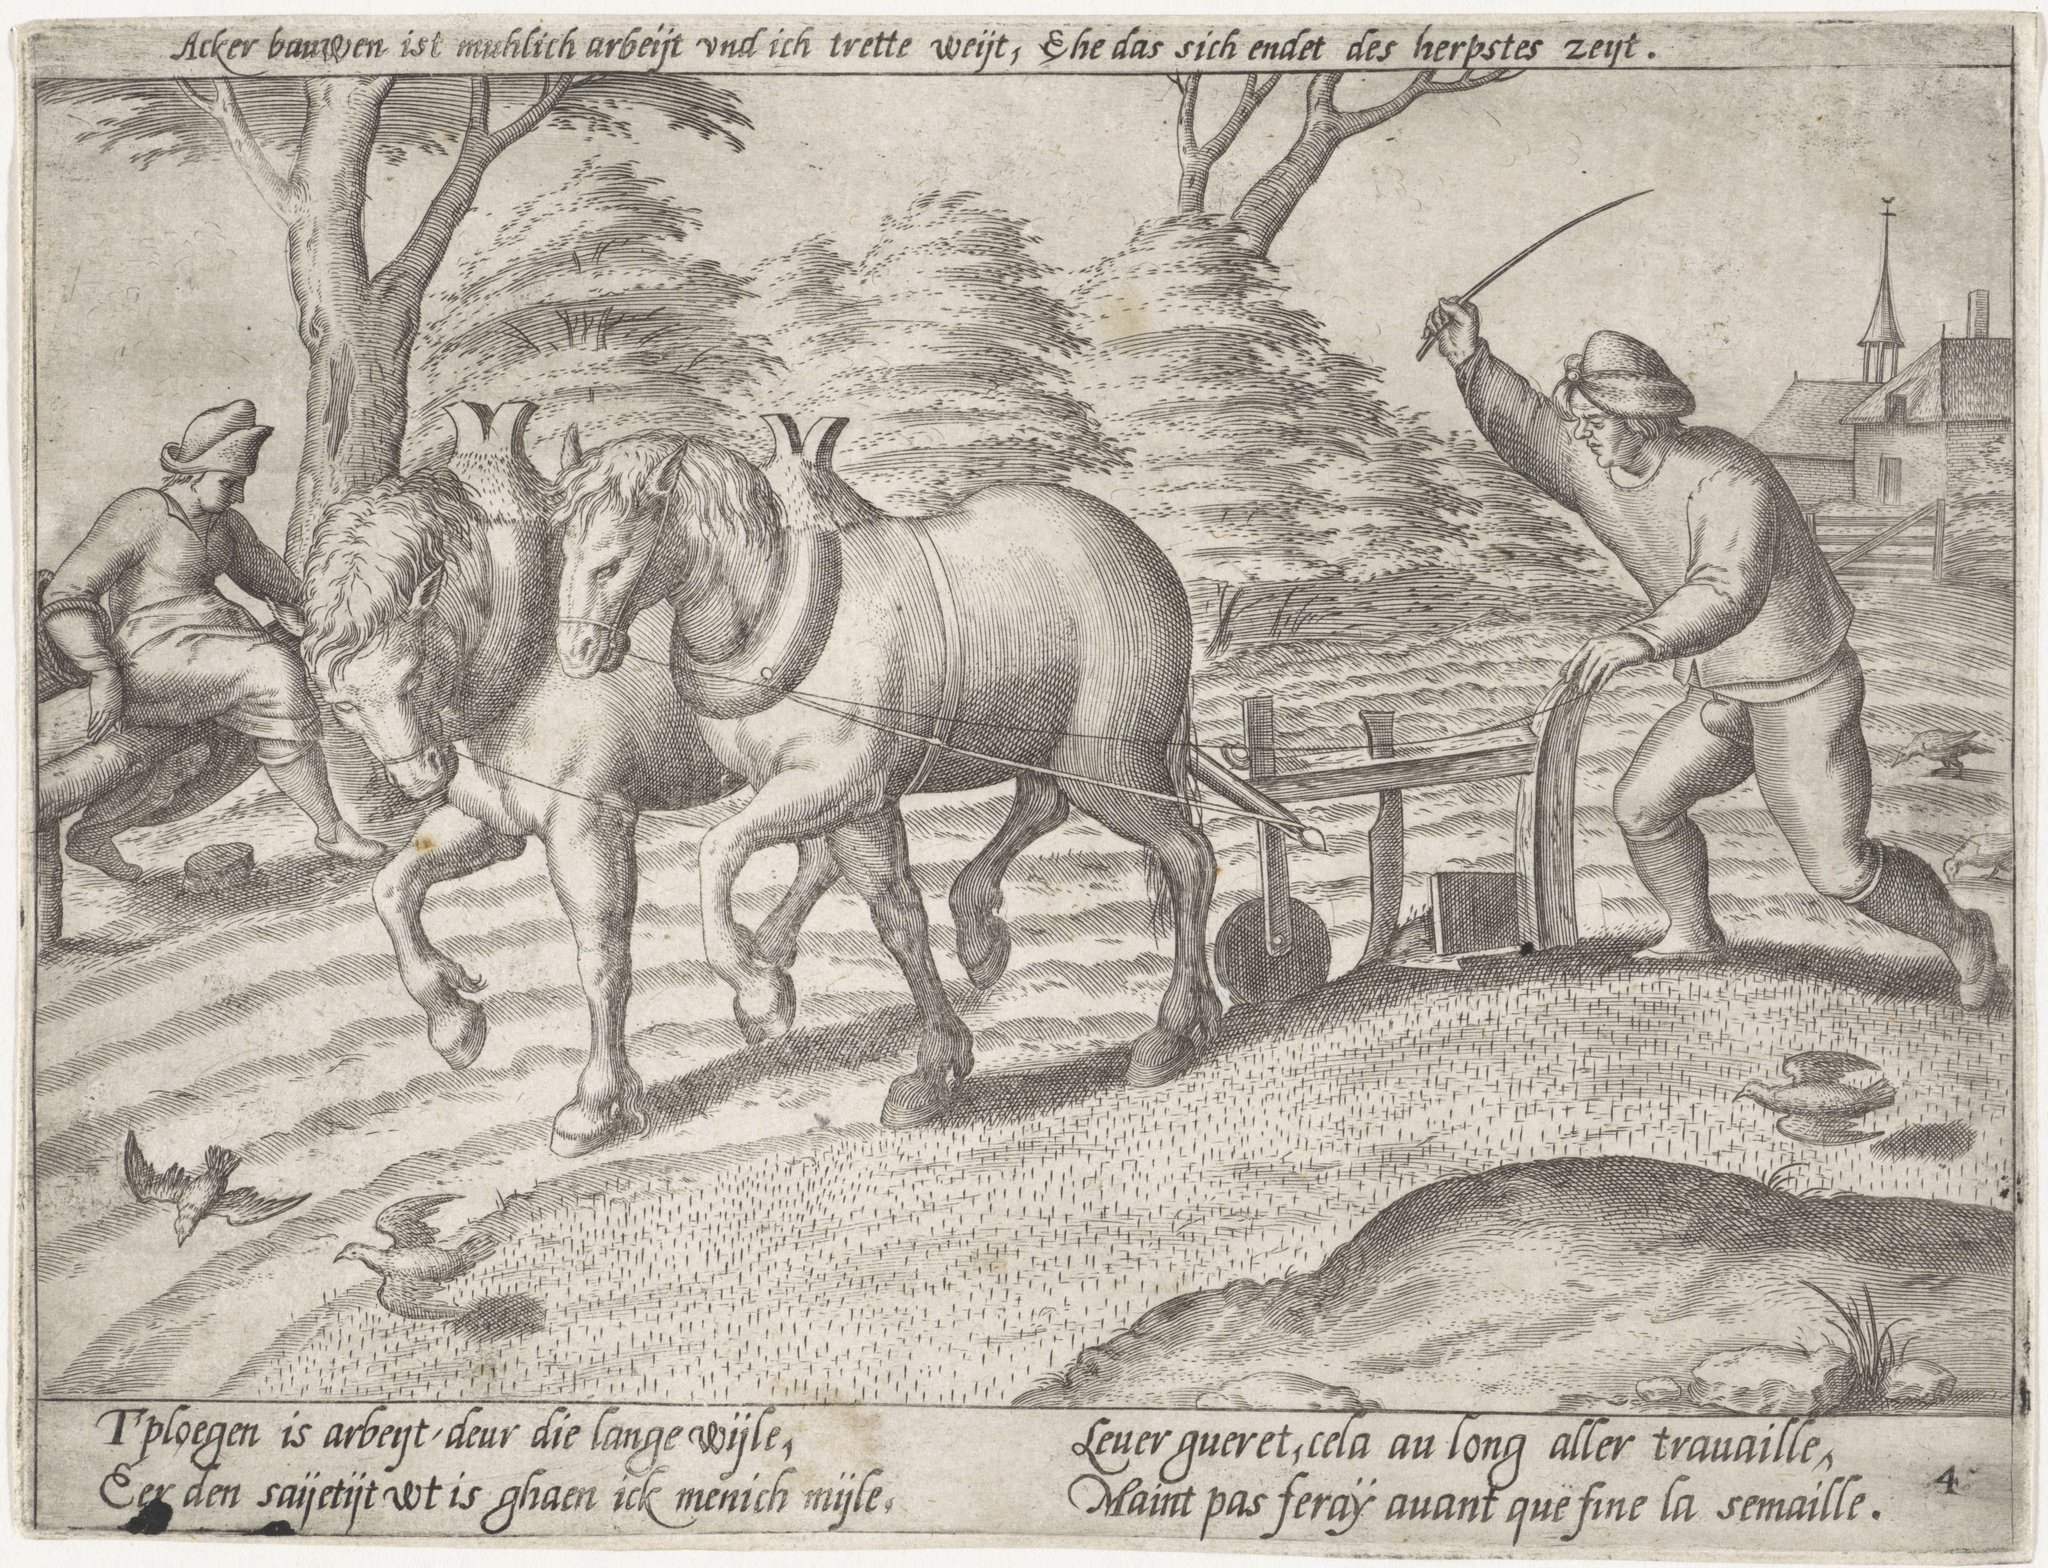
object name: print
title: Ploegen van het land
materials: paper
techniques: engraving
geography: antwerp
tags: ploughing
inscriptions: collector's mark: Lugt 2228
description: Een boer ploegt zijn akker. Hij drijft zijn voor de wielploeg gespannen paarden voort met een zweep. Vogels pikken korrels uit het omgeploegde land. Op de prent een toelichting op de voorstelling in het Duits, het Nederlands en het Frans.